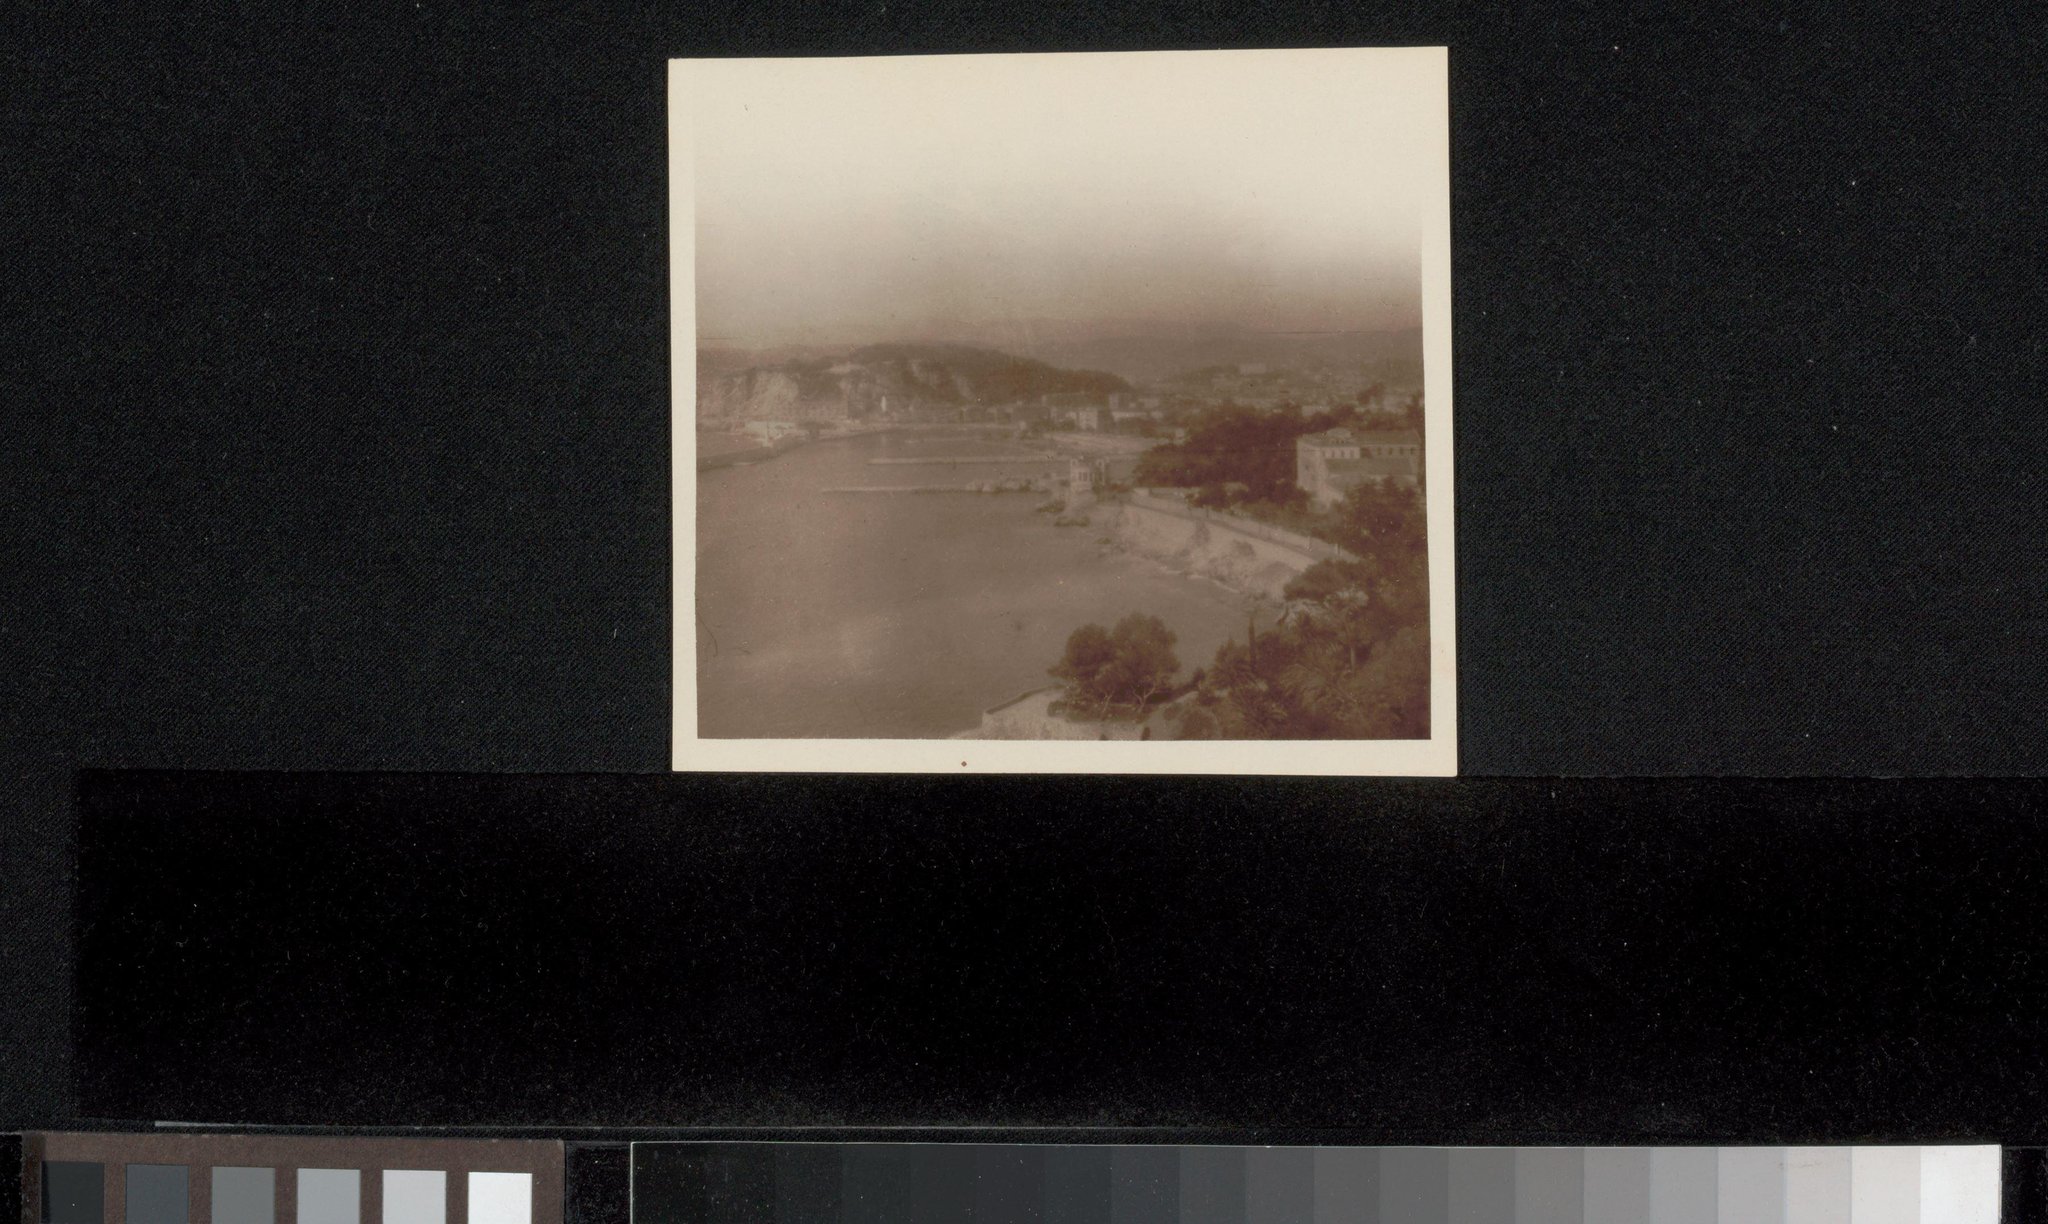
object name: photograph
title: Foto uit archief Philip Zilcken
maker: Anonymous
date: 1911-1941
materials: photographic support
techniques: printing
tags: the hague, painter, philip zilcken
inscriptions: collector's mark: ‘RPK’